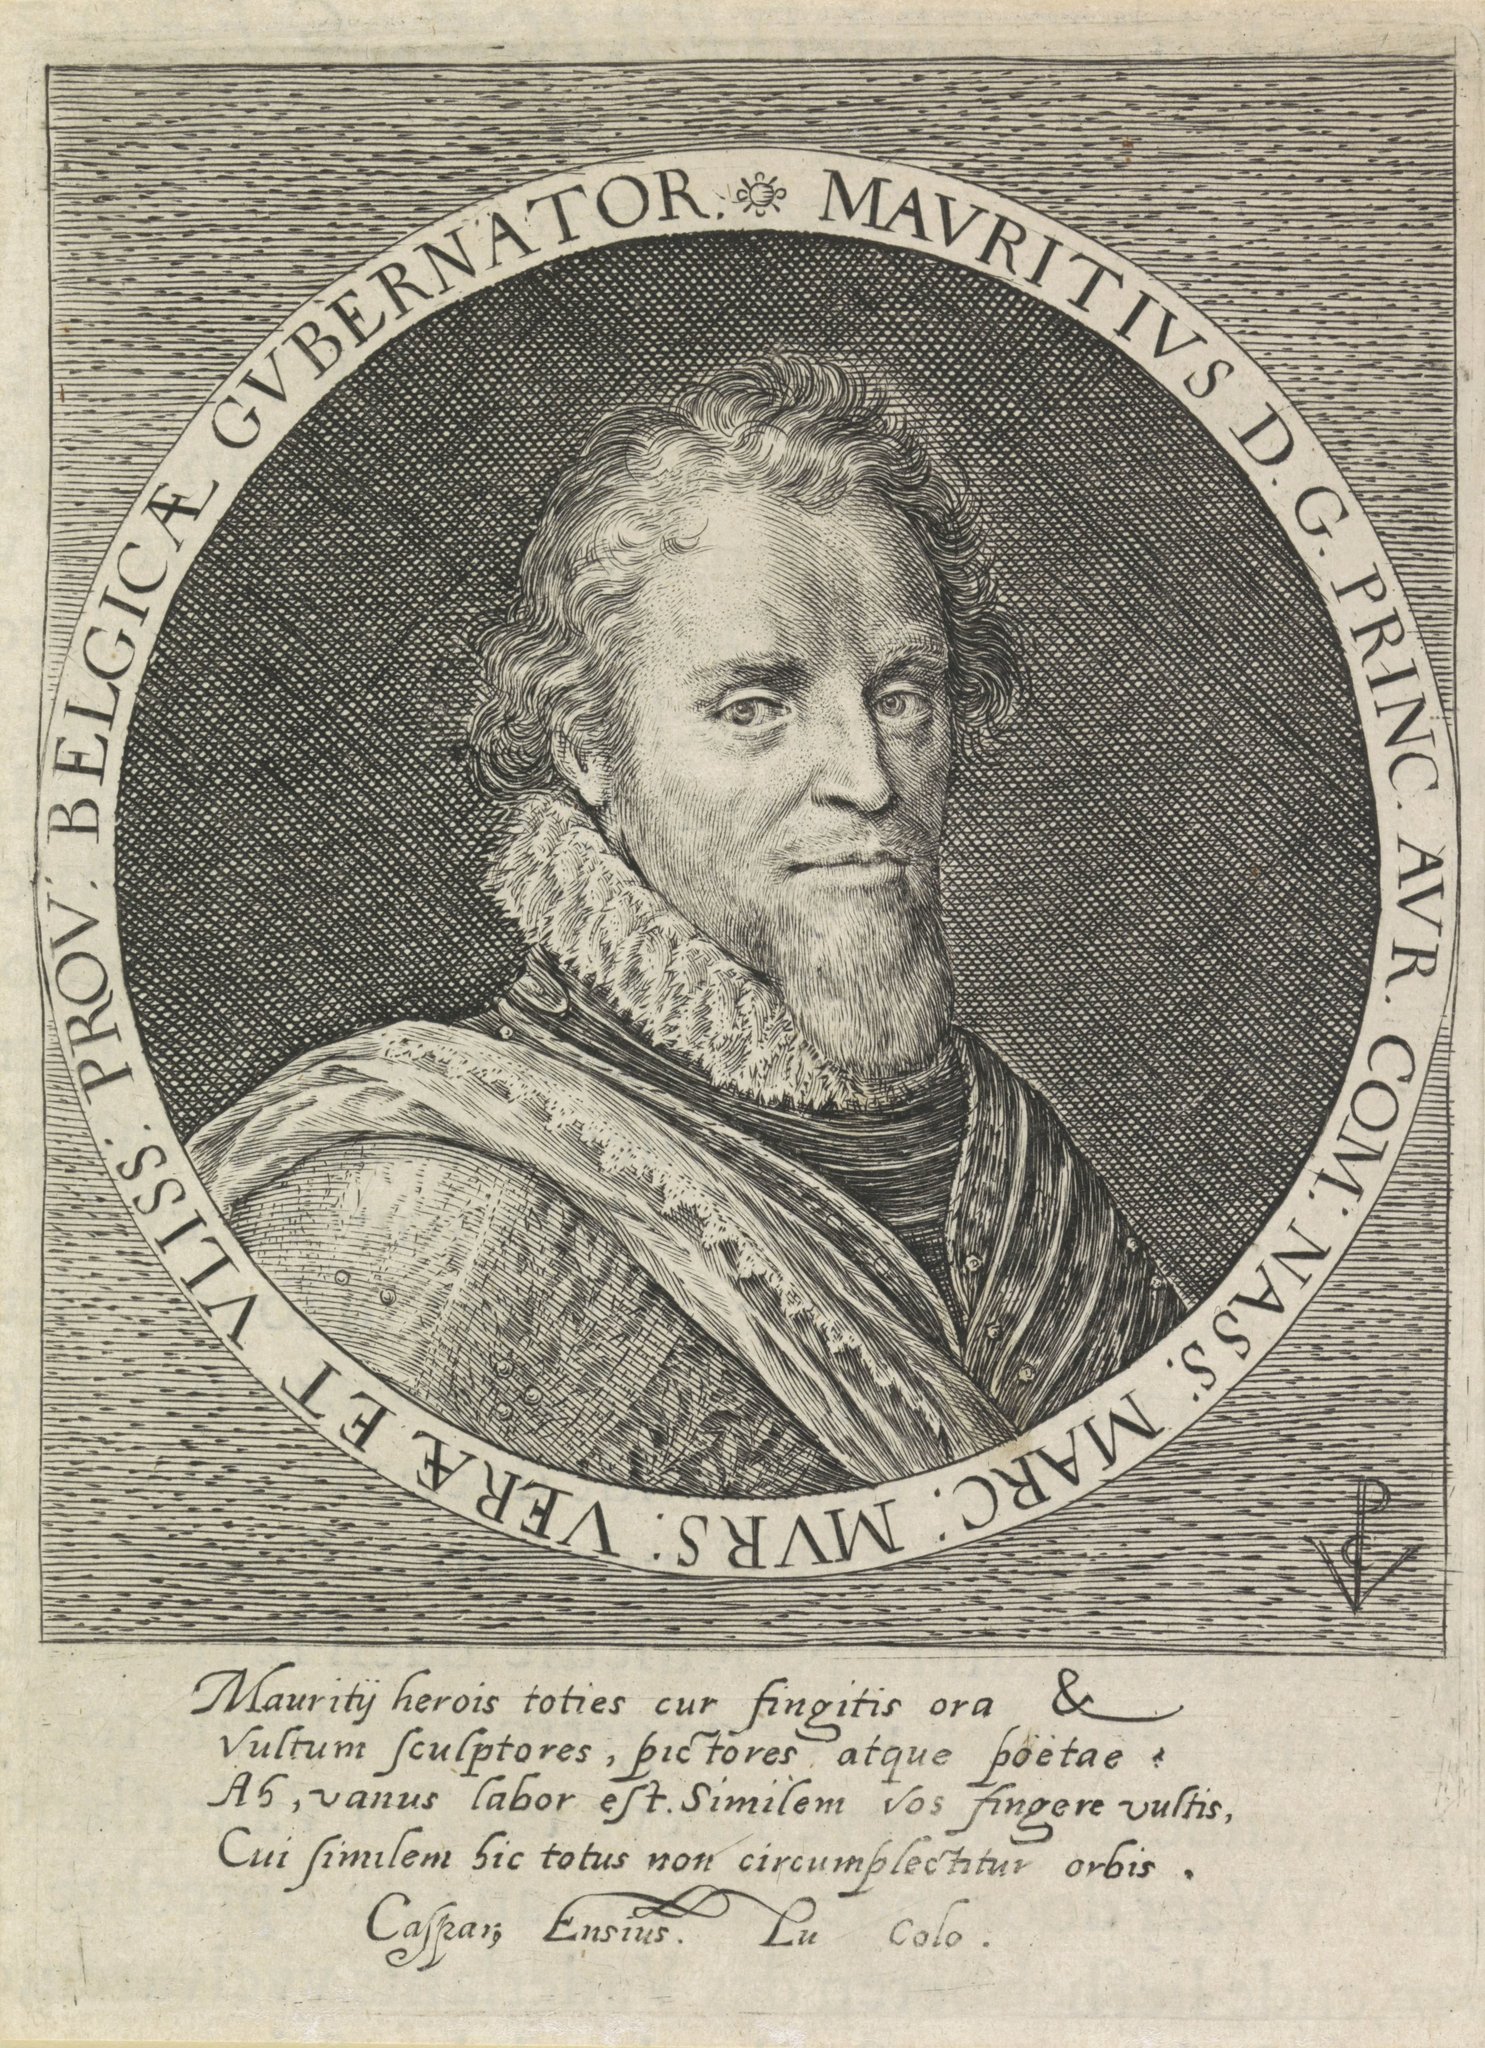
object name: book illustration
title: Portret van Maurits, prins van Oranje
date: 1615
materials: paper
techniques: engraving, etching, letterpress printing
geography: utrecht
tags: maurice (prince of orange)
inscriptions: collector's mark: Lugt 963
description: De hier vermelde titel verwijst naar de hoogst verkregen titel van de geportretteerde, niet per se naar de titel die de geportretteerde op deze voorstelling draagt. Prent uit: Buchelius, Arnoldus. Nassovischen Oraignen-boom, daer by ghevoecht, de conterfeytsels der voornaemster helden. = Malus Aurantius Nassovicus. Utrecht: Salomon de Roy, 1615.